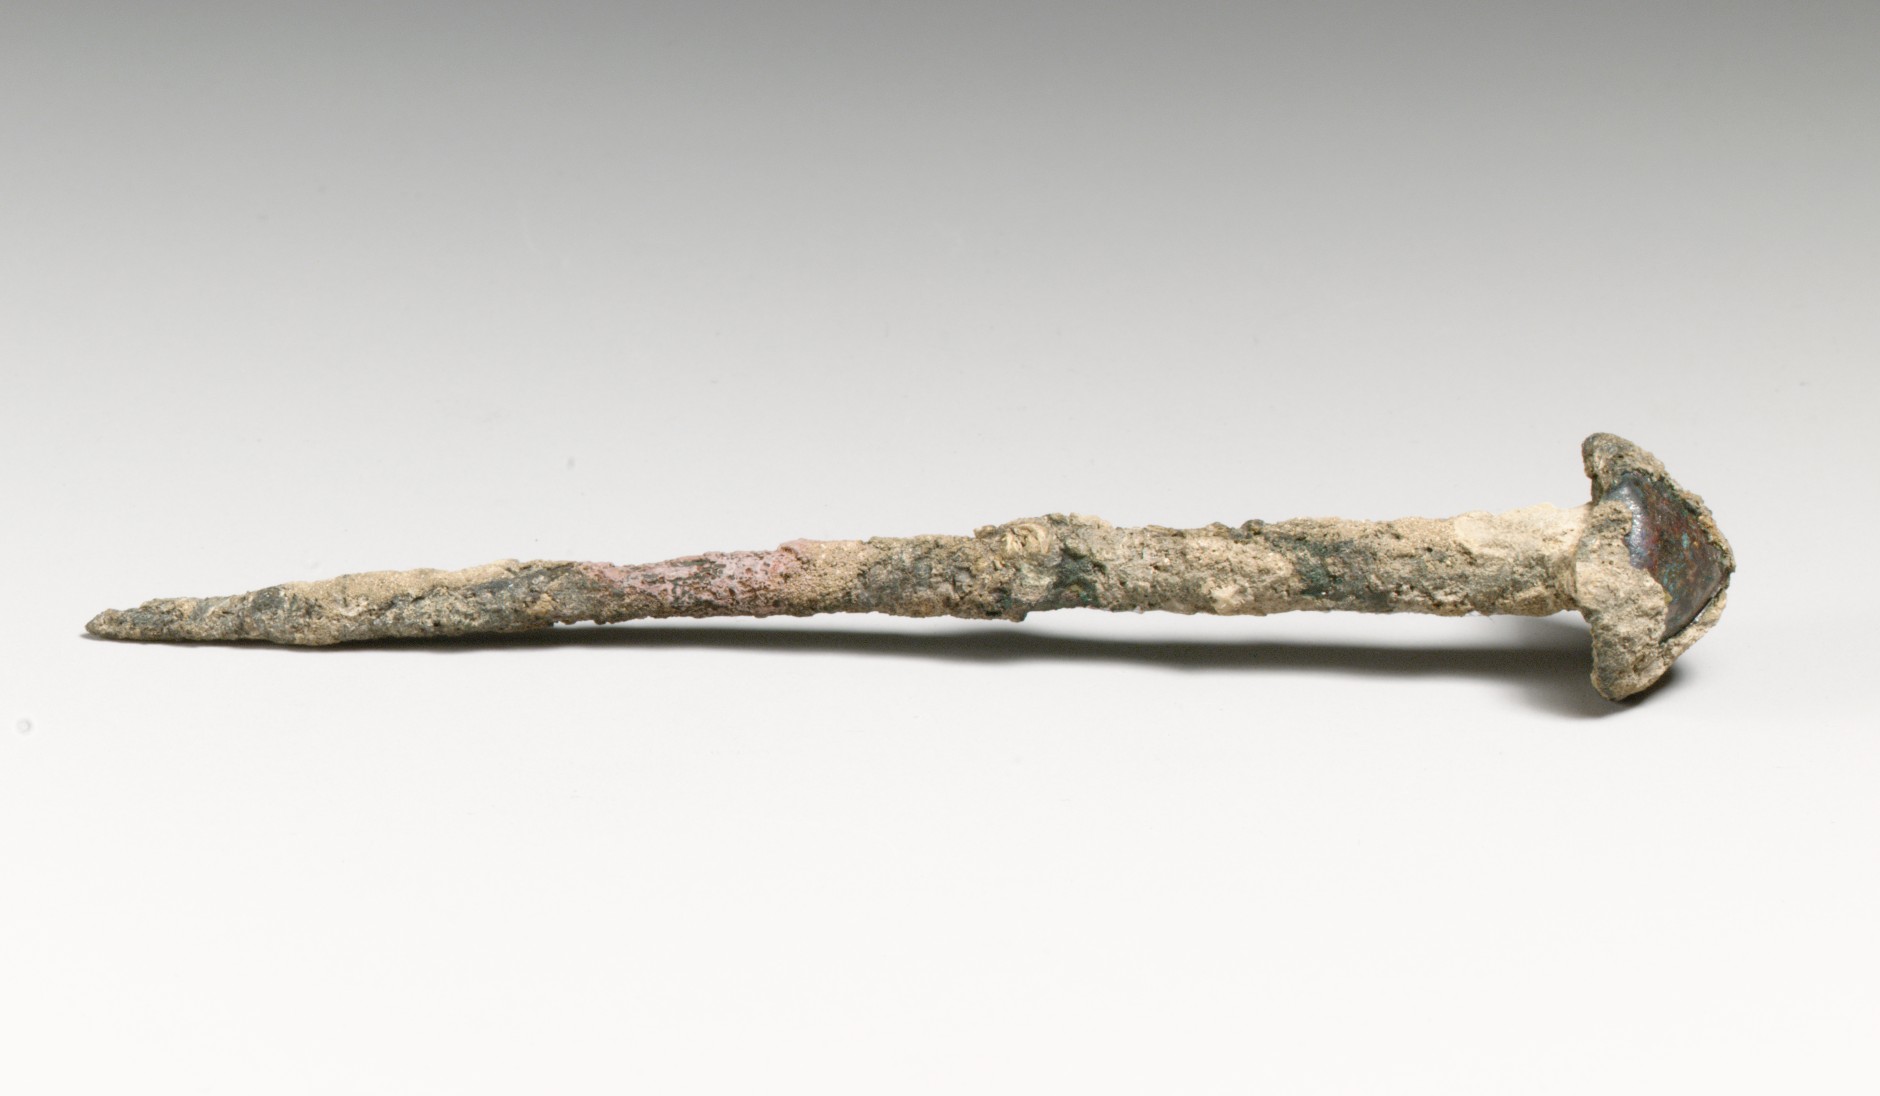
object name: pin, eyelet type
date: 7000 BCE-330 CE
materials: bronze